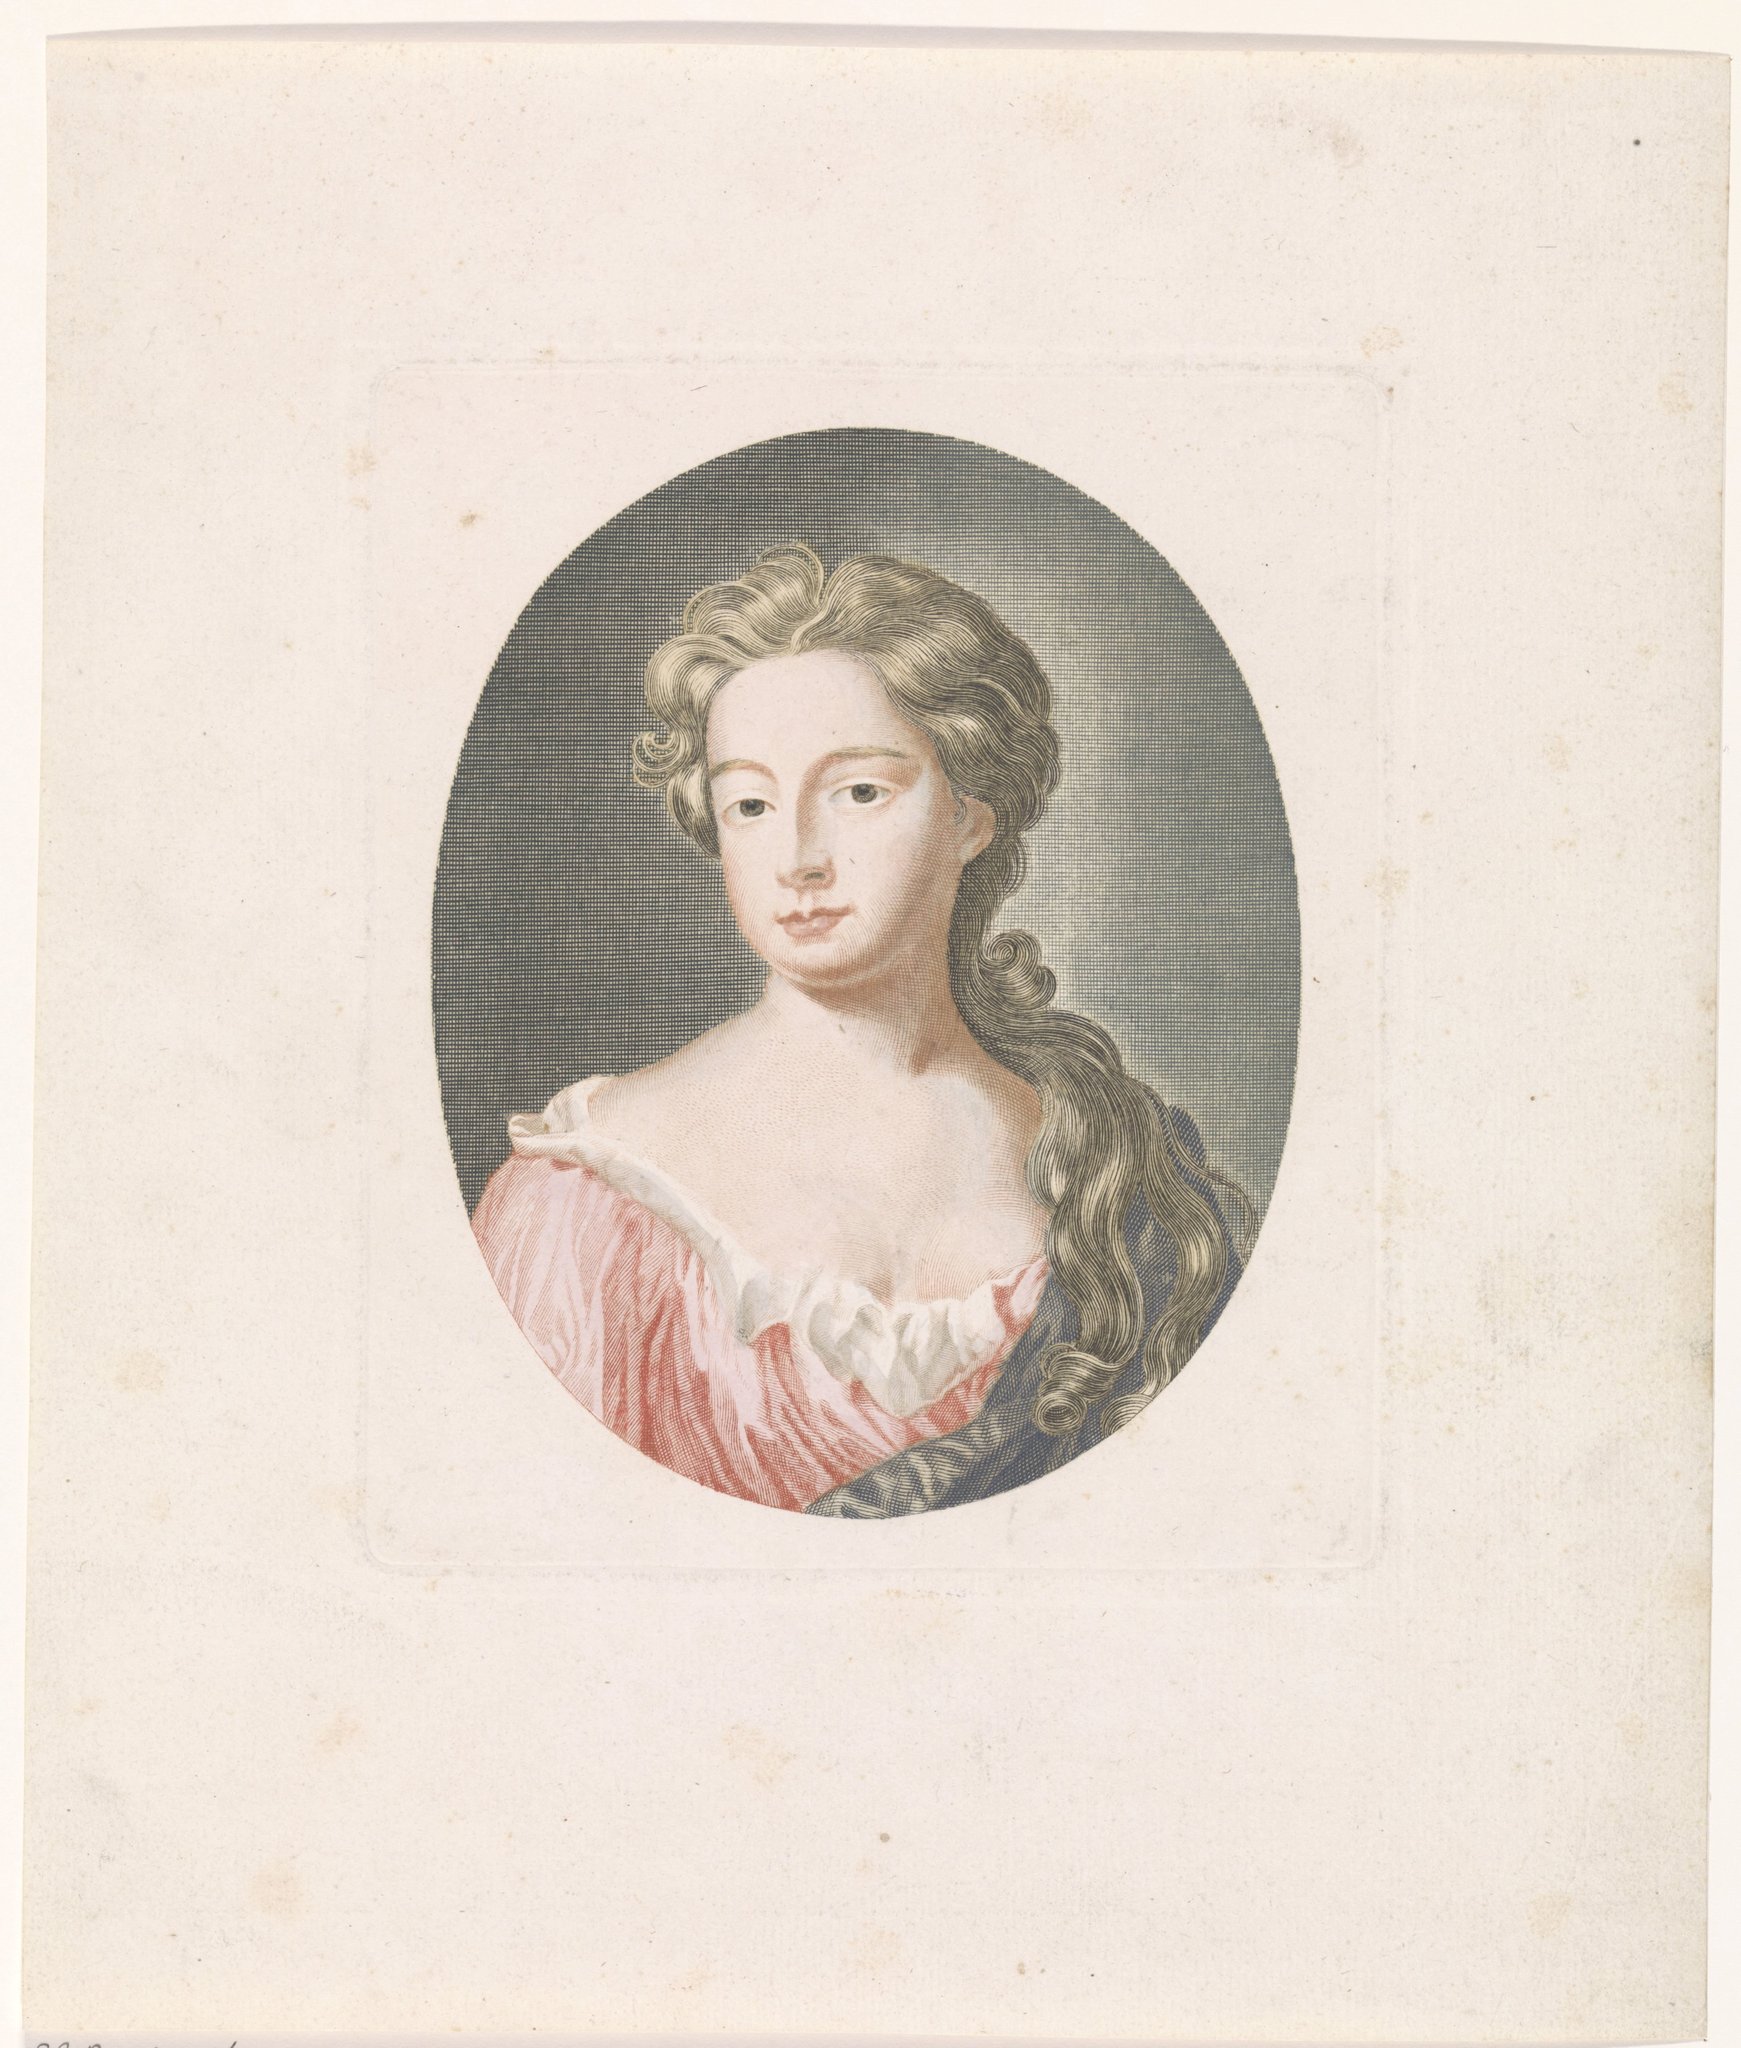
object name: print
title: Portret van een vrouw met lang haar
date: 1688-1698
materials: paper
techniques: printing, engraving, lithography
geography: netherlands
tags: adult woman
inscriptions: collector's mark: Lugt 2760